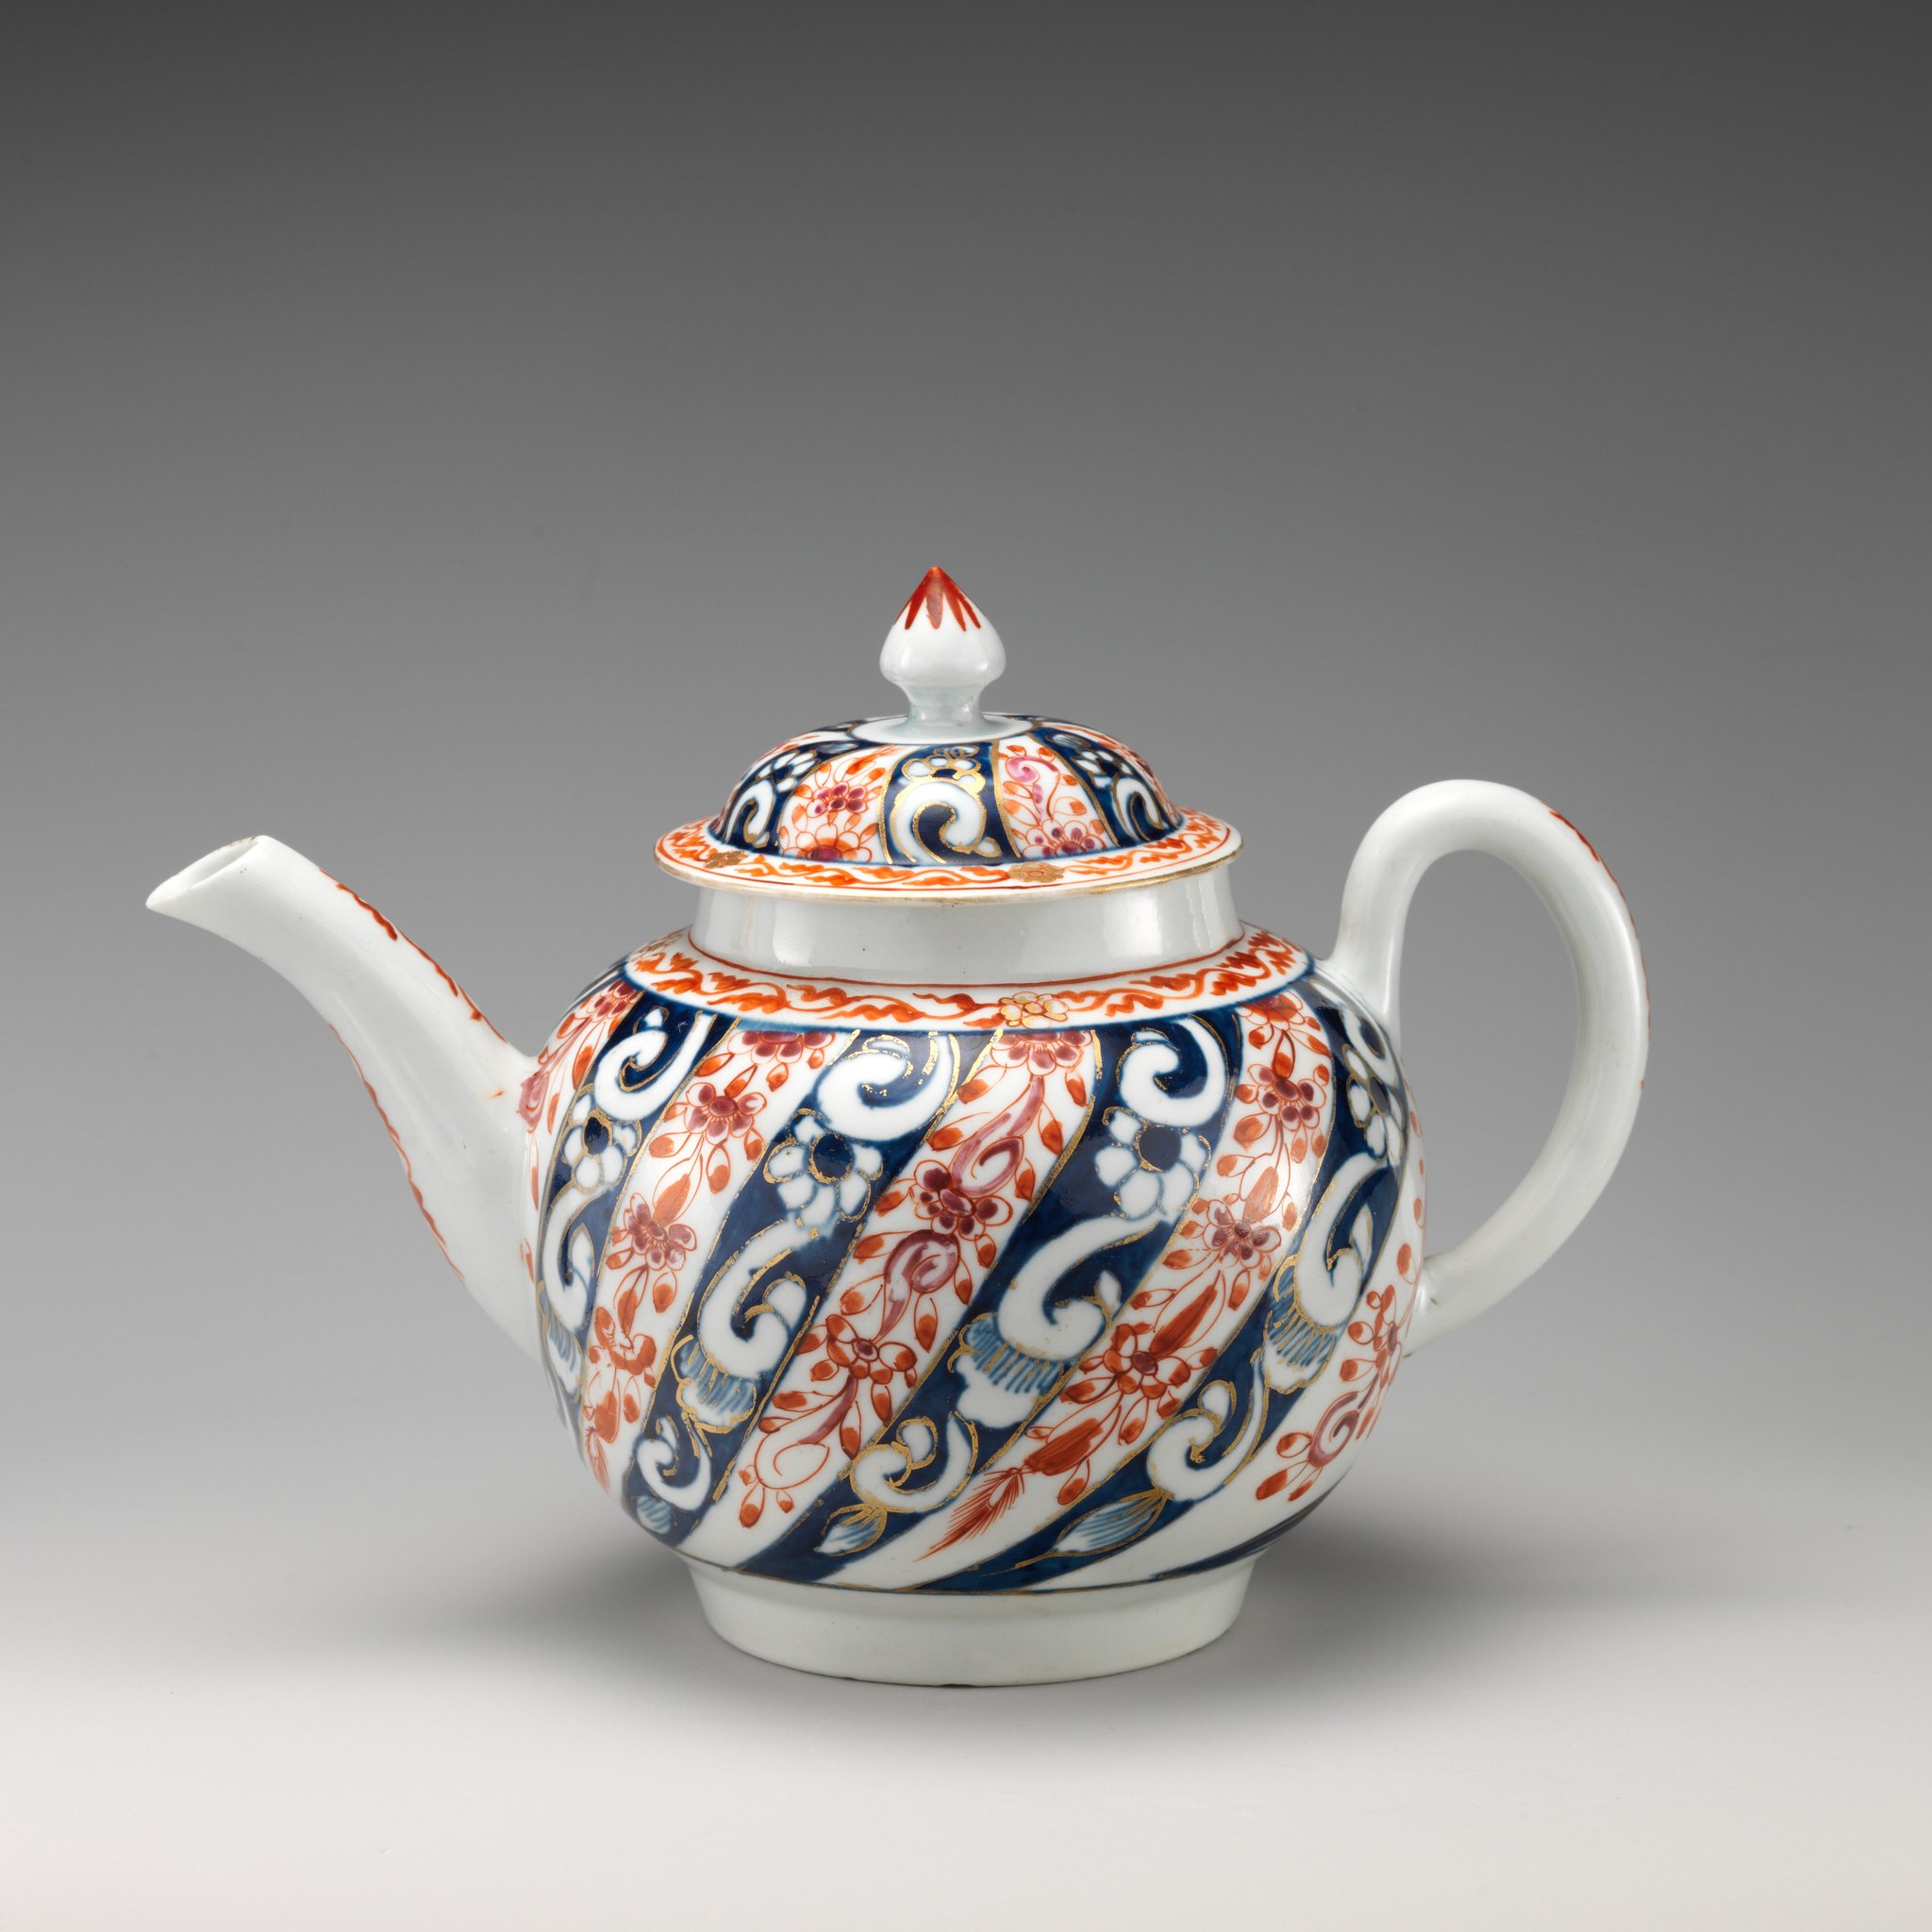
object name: teapot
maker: worcester factory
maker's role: factory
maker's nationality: british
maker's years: 1751-2008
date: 1770-1780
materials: enamel, soft paste porcelain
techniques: gilding